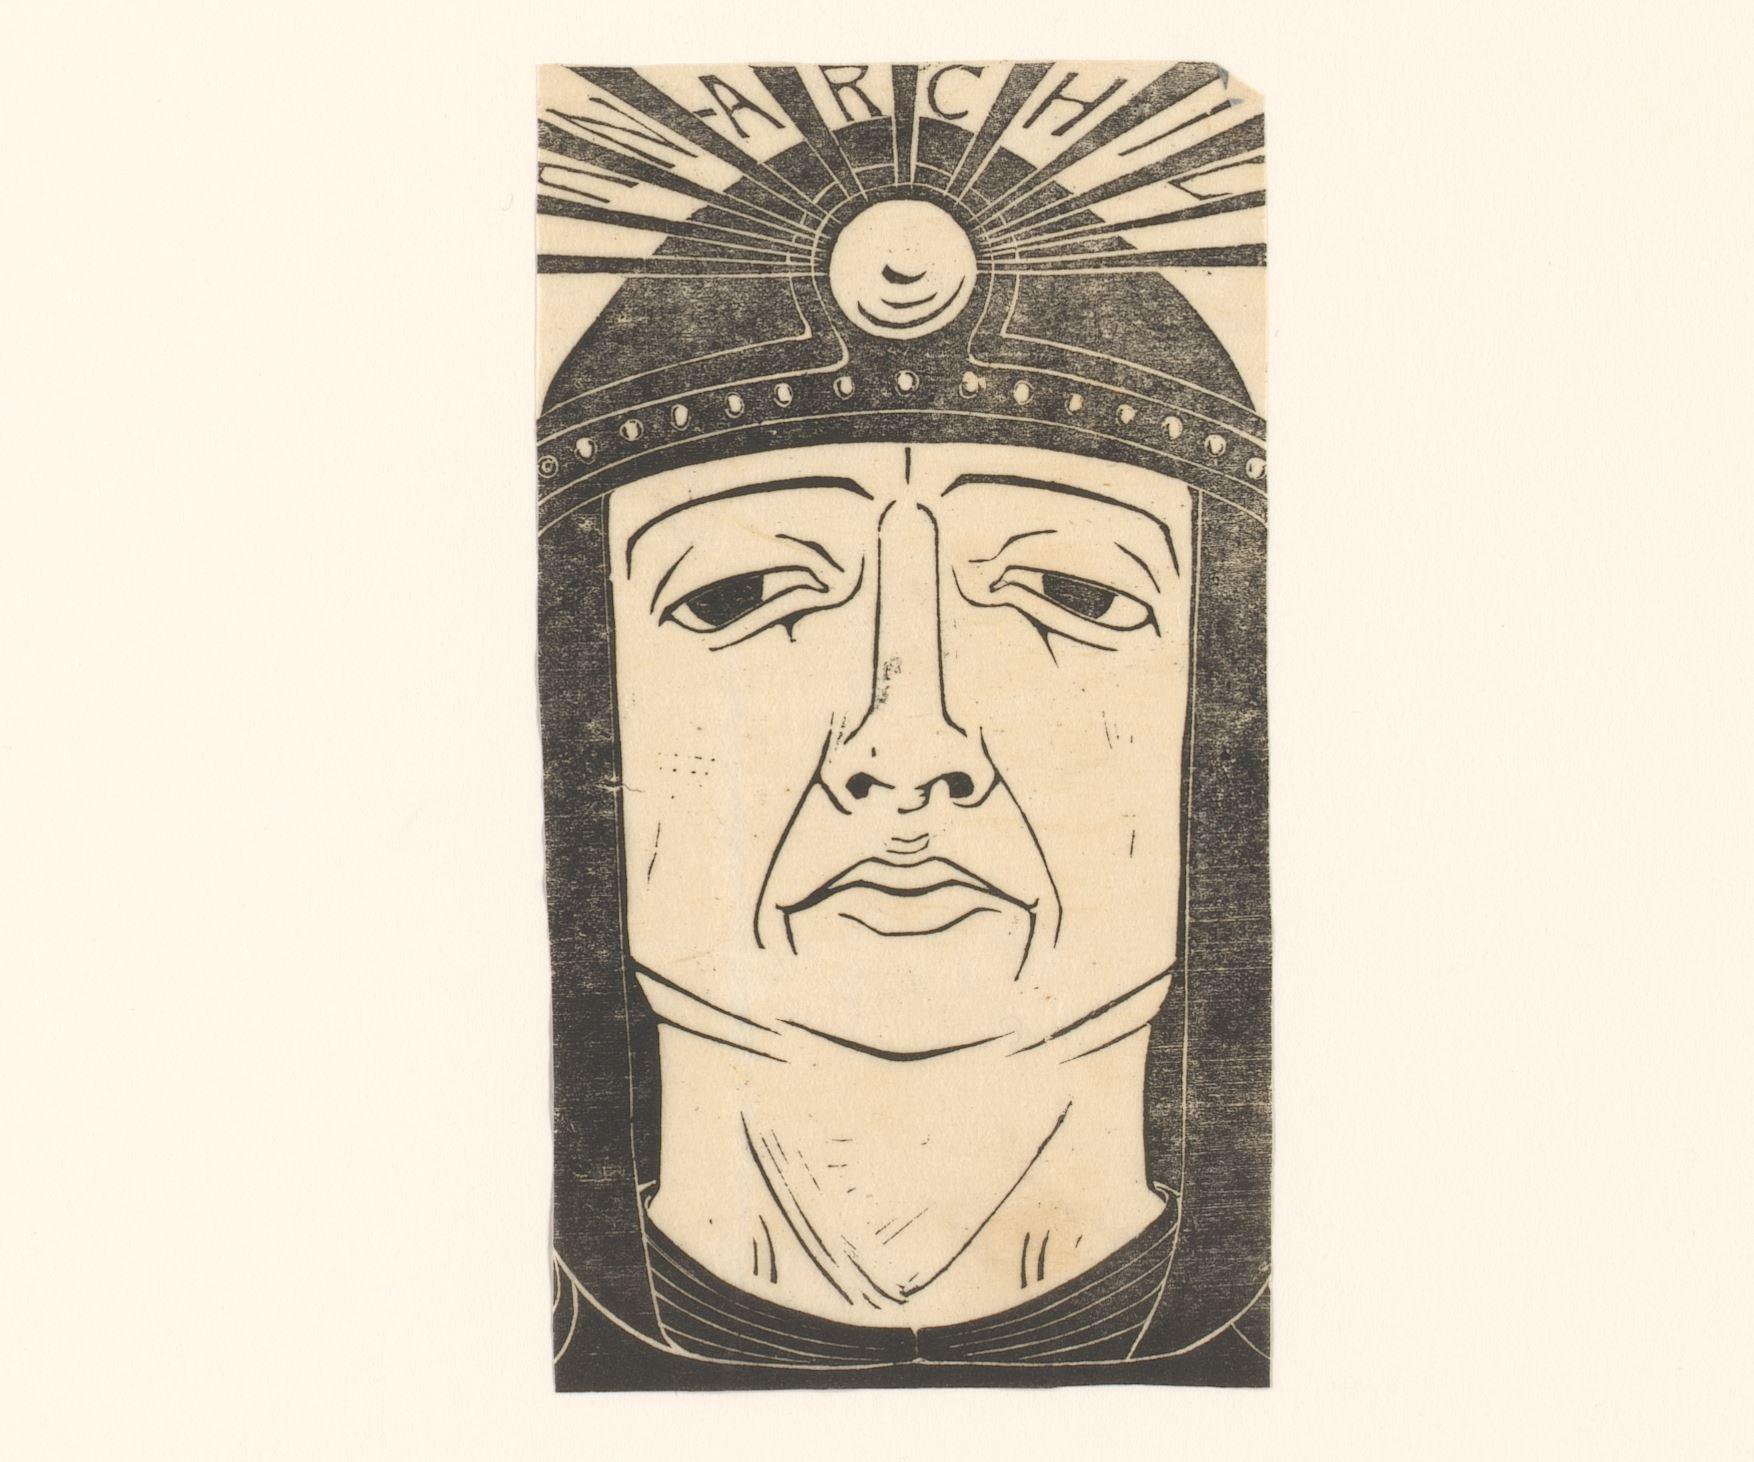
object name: print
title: Argonauten: Psychische kracht onaantastbaar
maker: karel petrus cornelis de bazel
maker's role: draughtsman, print maker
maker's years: 1869-1923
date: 1894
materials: paper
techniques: woodcut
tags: helmet, face, radiance emanating from persons or things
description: Enkel het middelste deel van de prent. Als geheel is deze prent gebruikt voor: Licht en waarheid. Orgaan van de Vereeniging 'Wie denkt overwint', 11 augustus 1894, bij 'De tocht der Argonauten'.